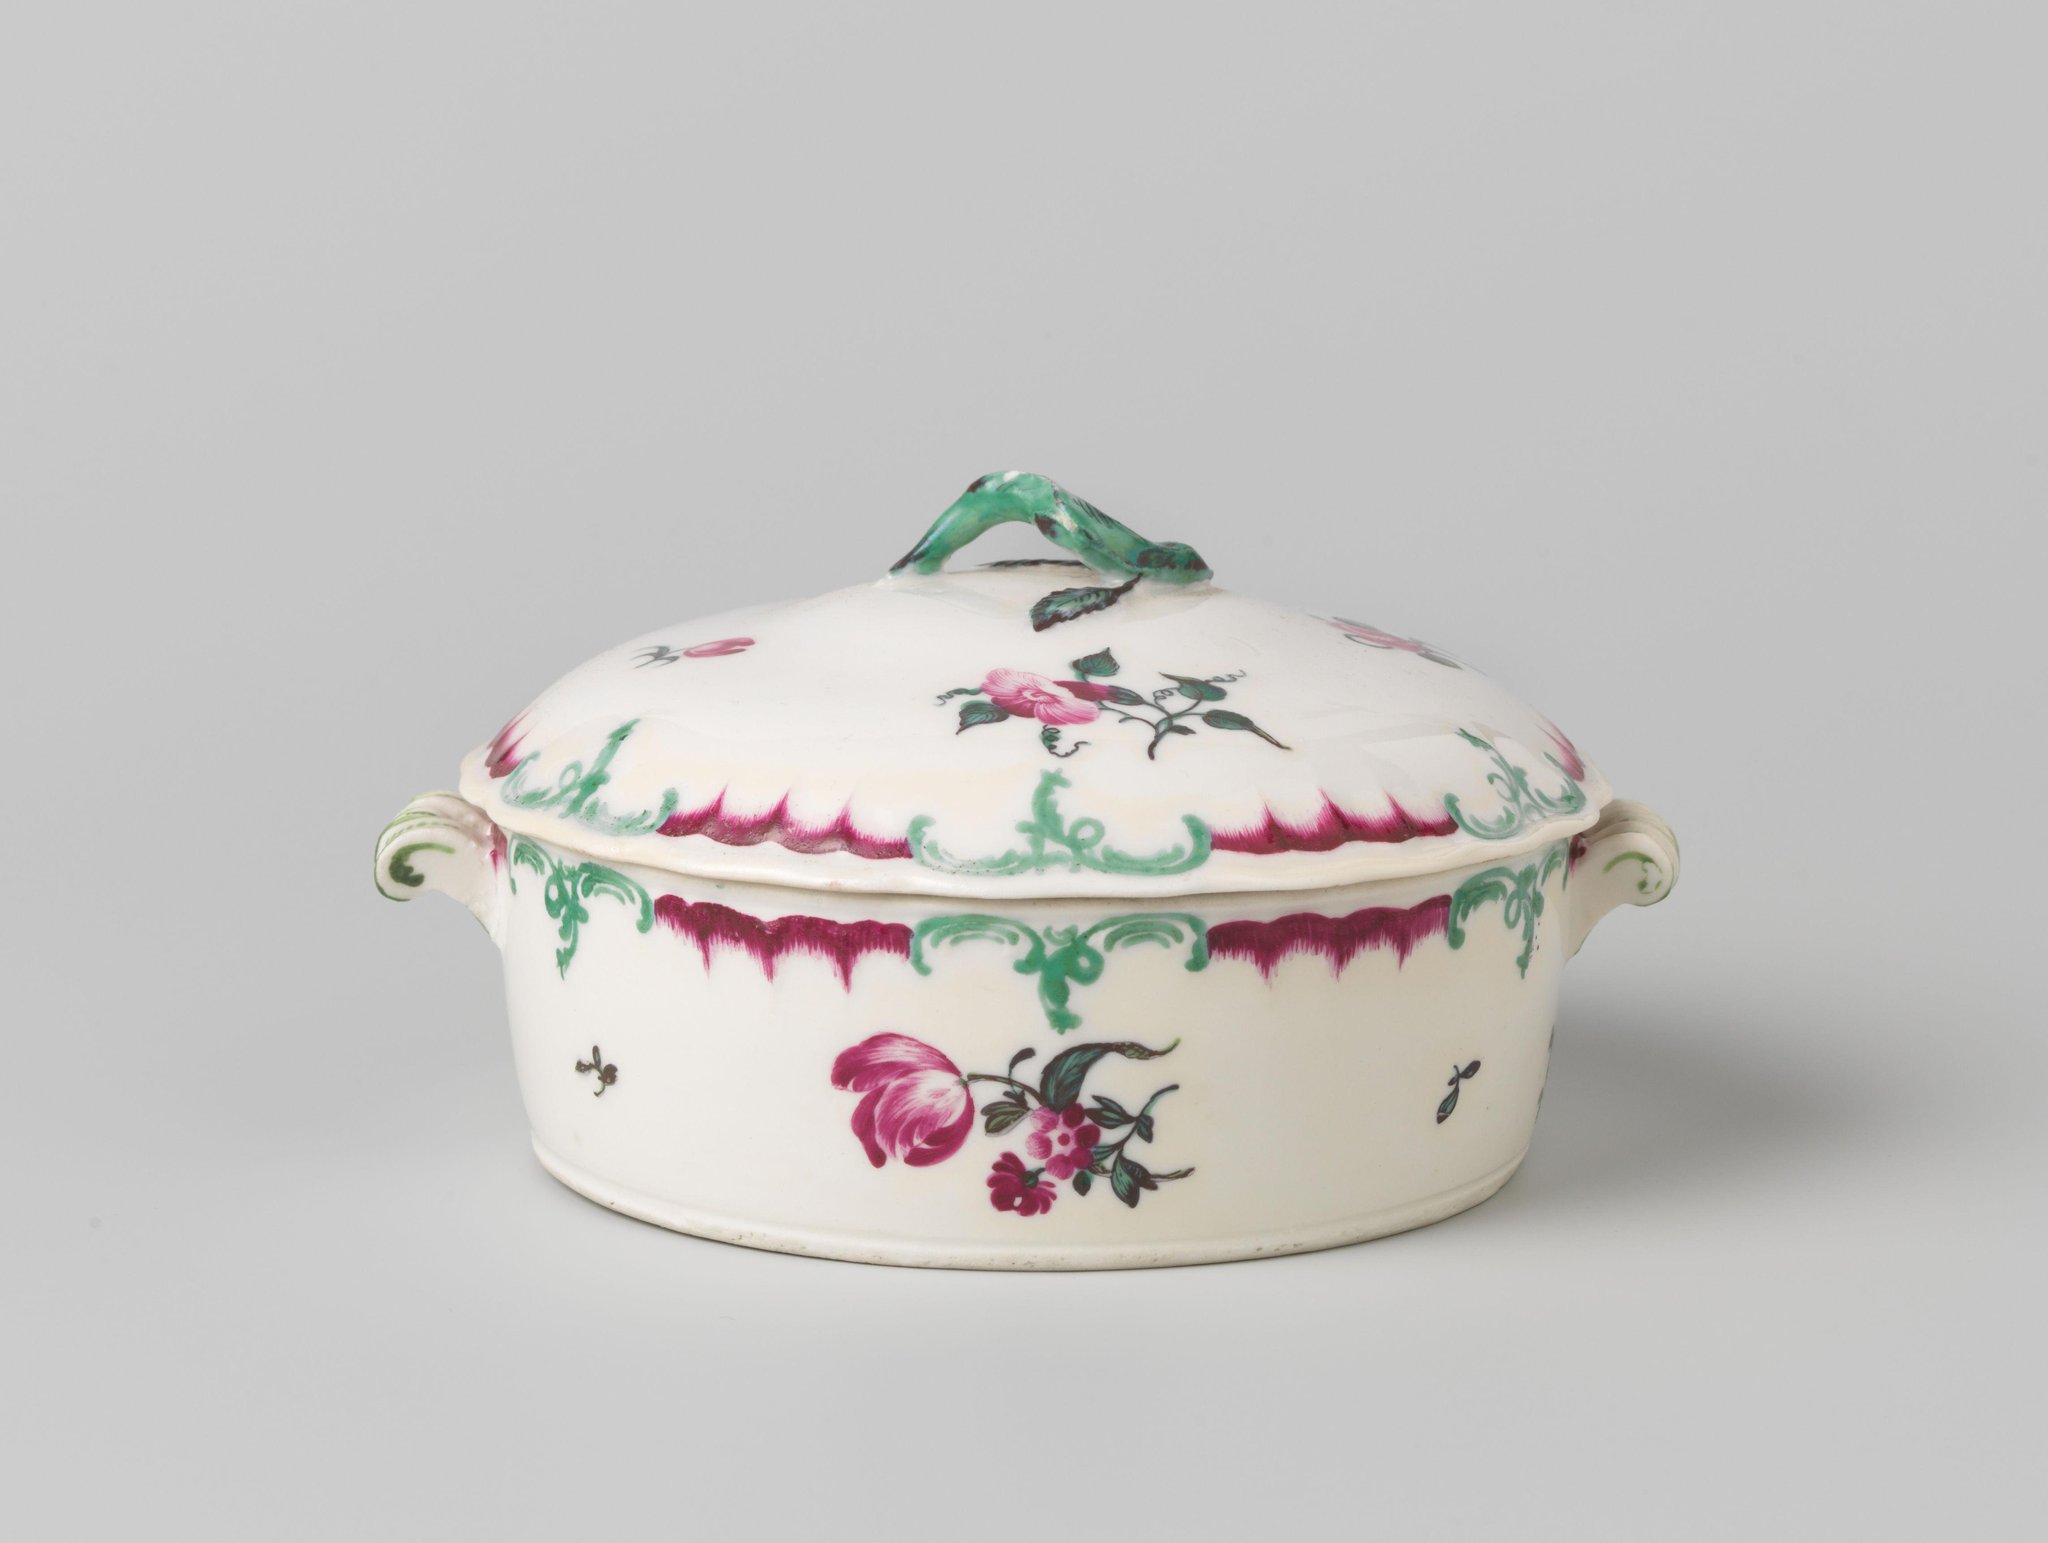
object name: lid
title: Deksel van botervloot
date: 1778-1782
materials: porcelain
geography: loosdrecht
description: Het deksel is geschulpt en heeft een groen takje als handvat. Langs de randen van botervloot en deksel rocailleornamenten in reliëf en beschilderd in bietenrood en lichtgroen. Wand en deksel beschilderd met bloemtakjes in bietenrood en twee kleuren groen, de oortjes in groen.